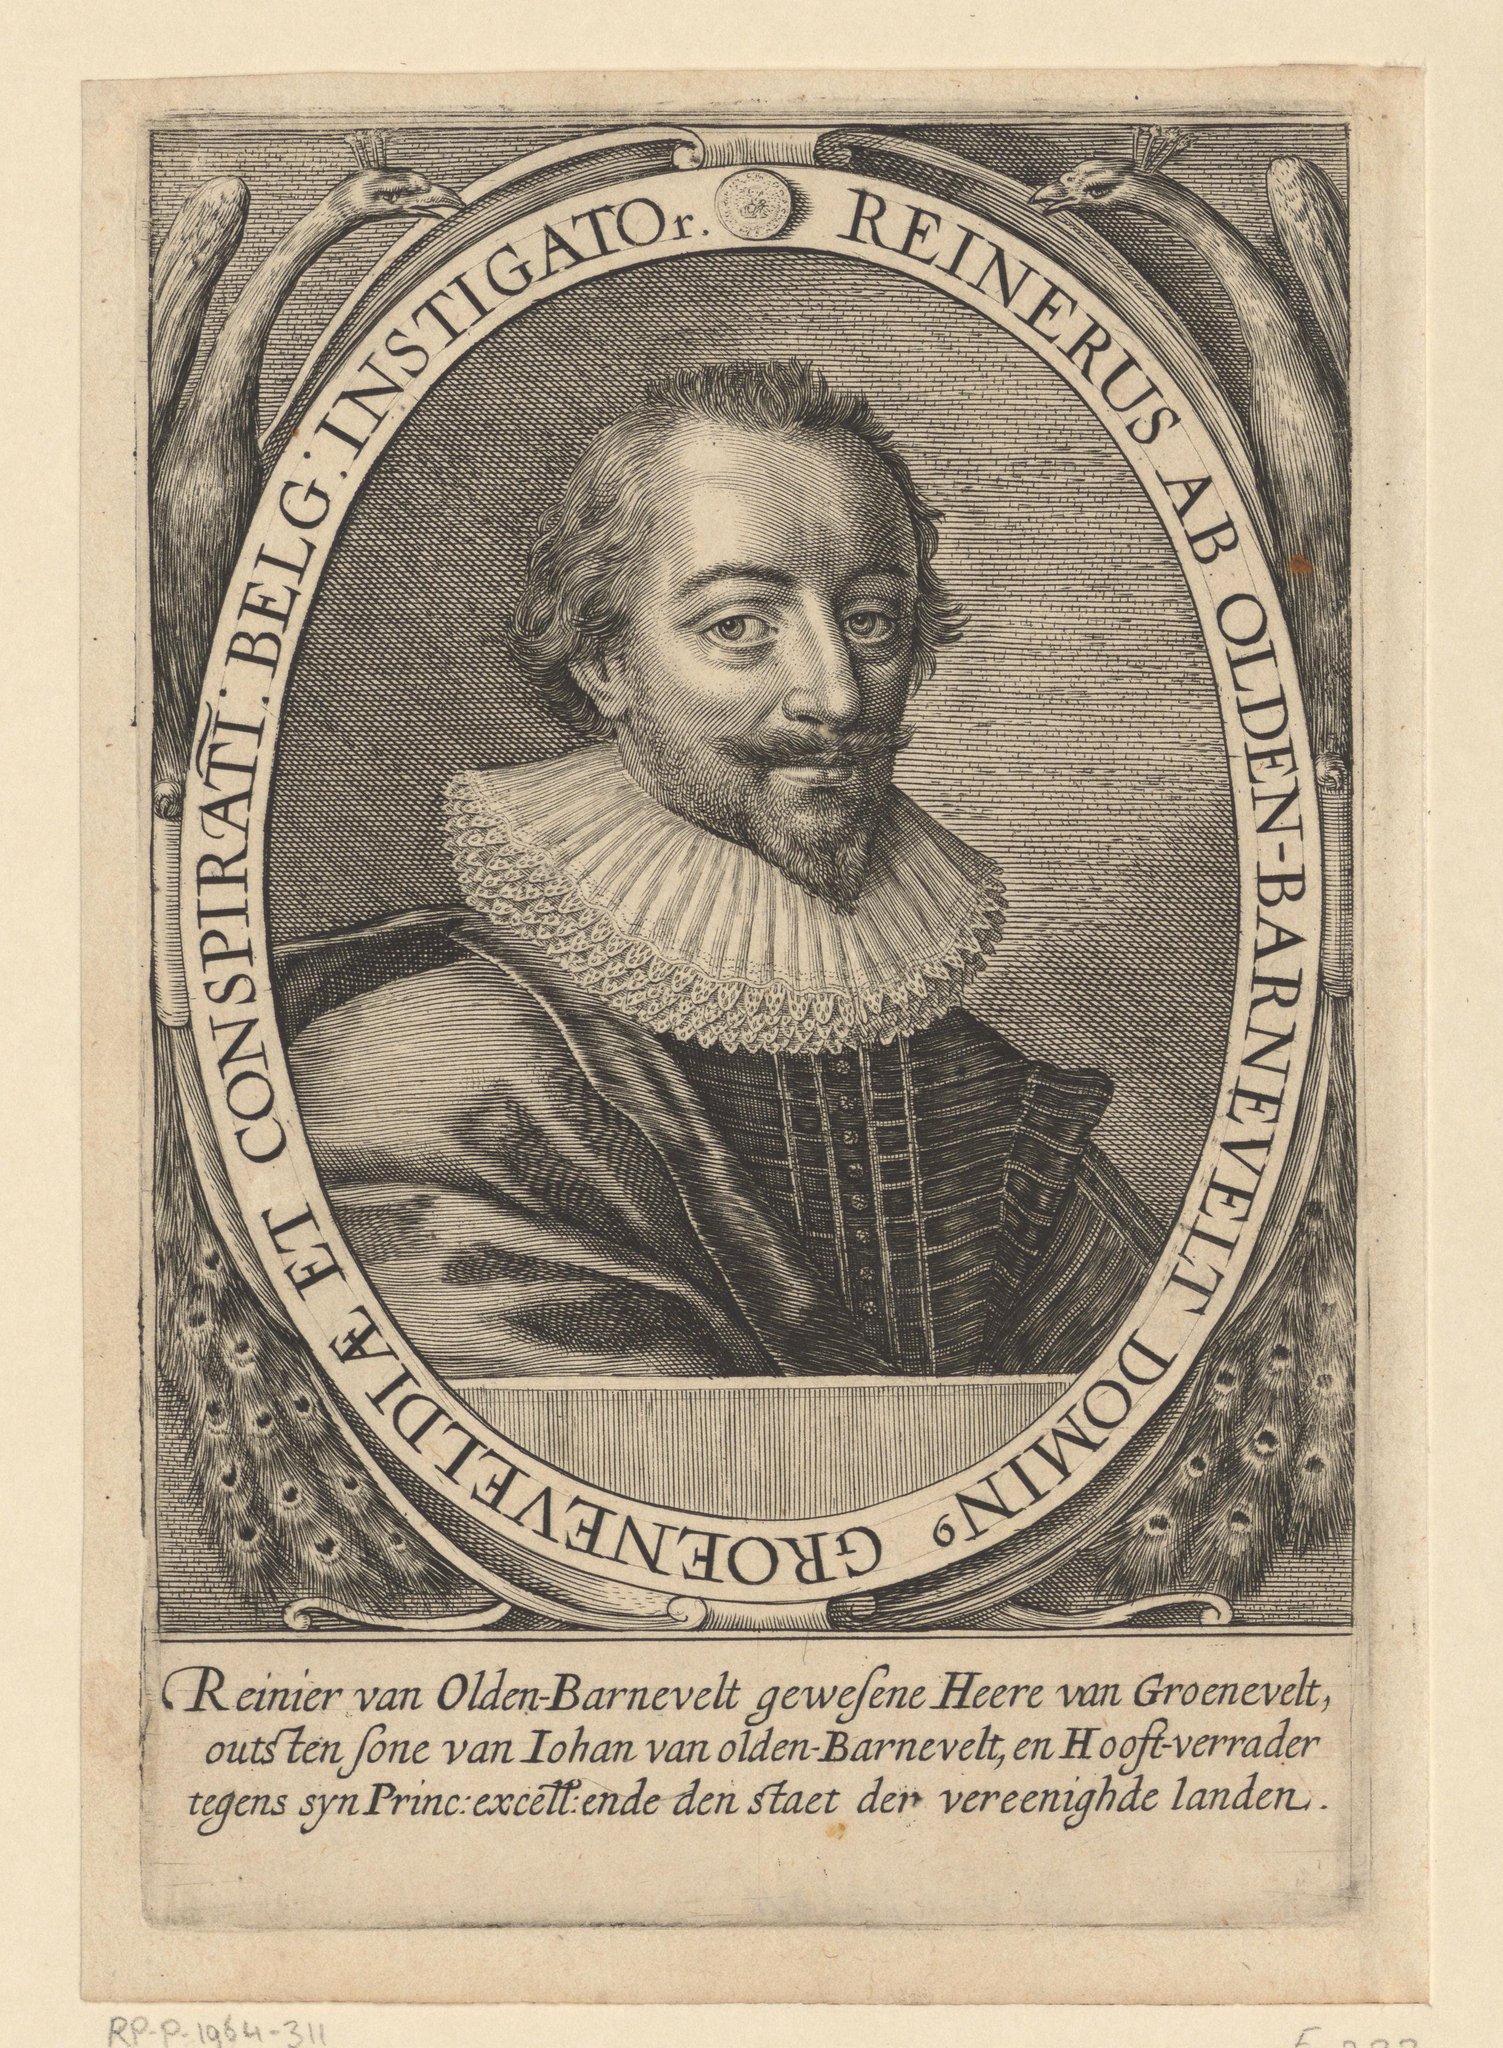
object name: print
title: Portret van Reinier van Oldenbarnevelt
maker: crispijn van de passe (i)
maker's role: draughtsman, print maker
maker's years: 1564-1637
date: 1623-1637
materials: paper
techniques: engraving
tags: the hague, historical persons, ornamental birds: peacock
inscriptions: collector's mark: Lugt 2228